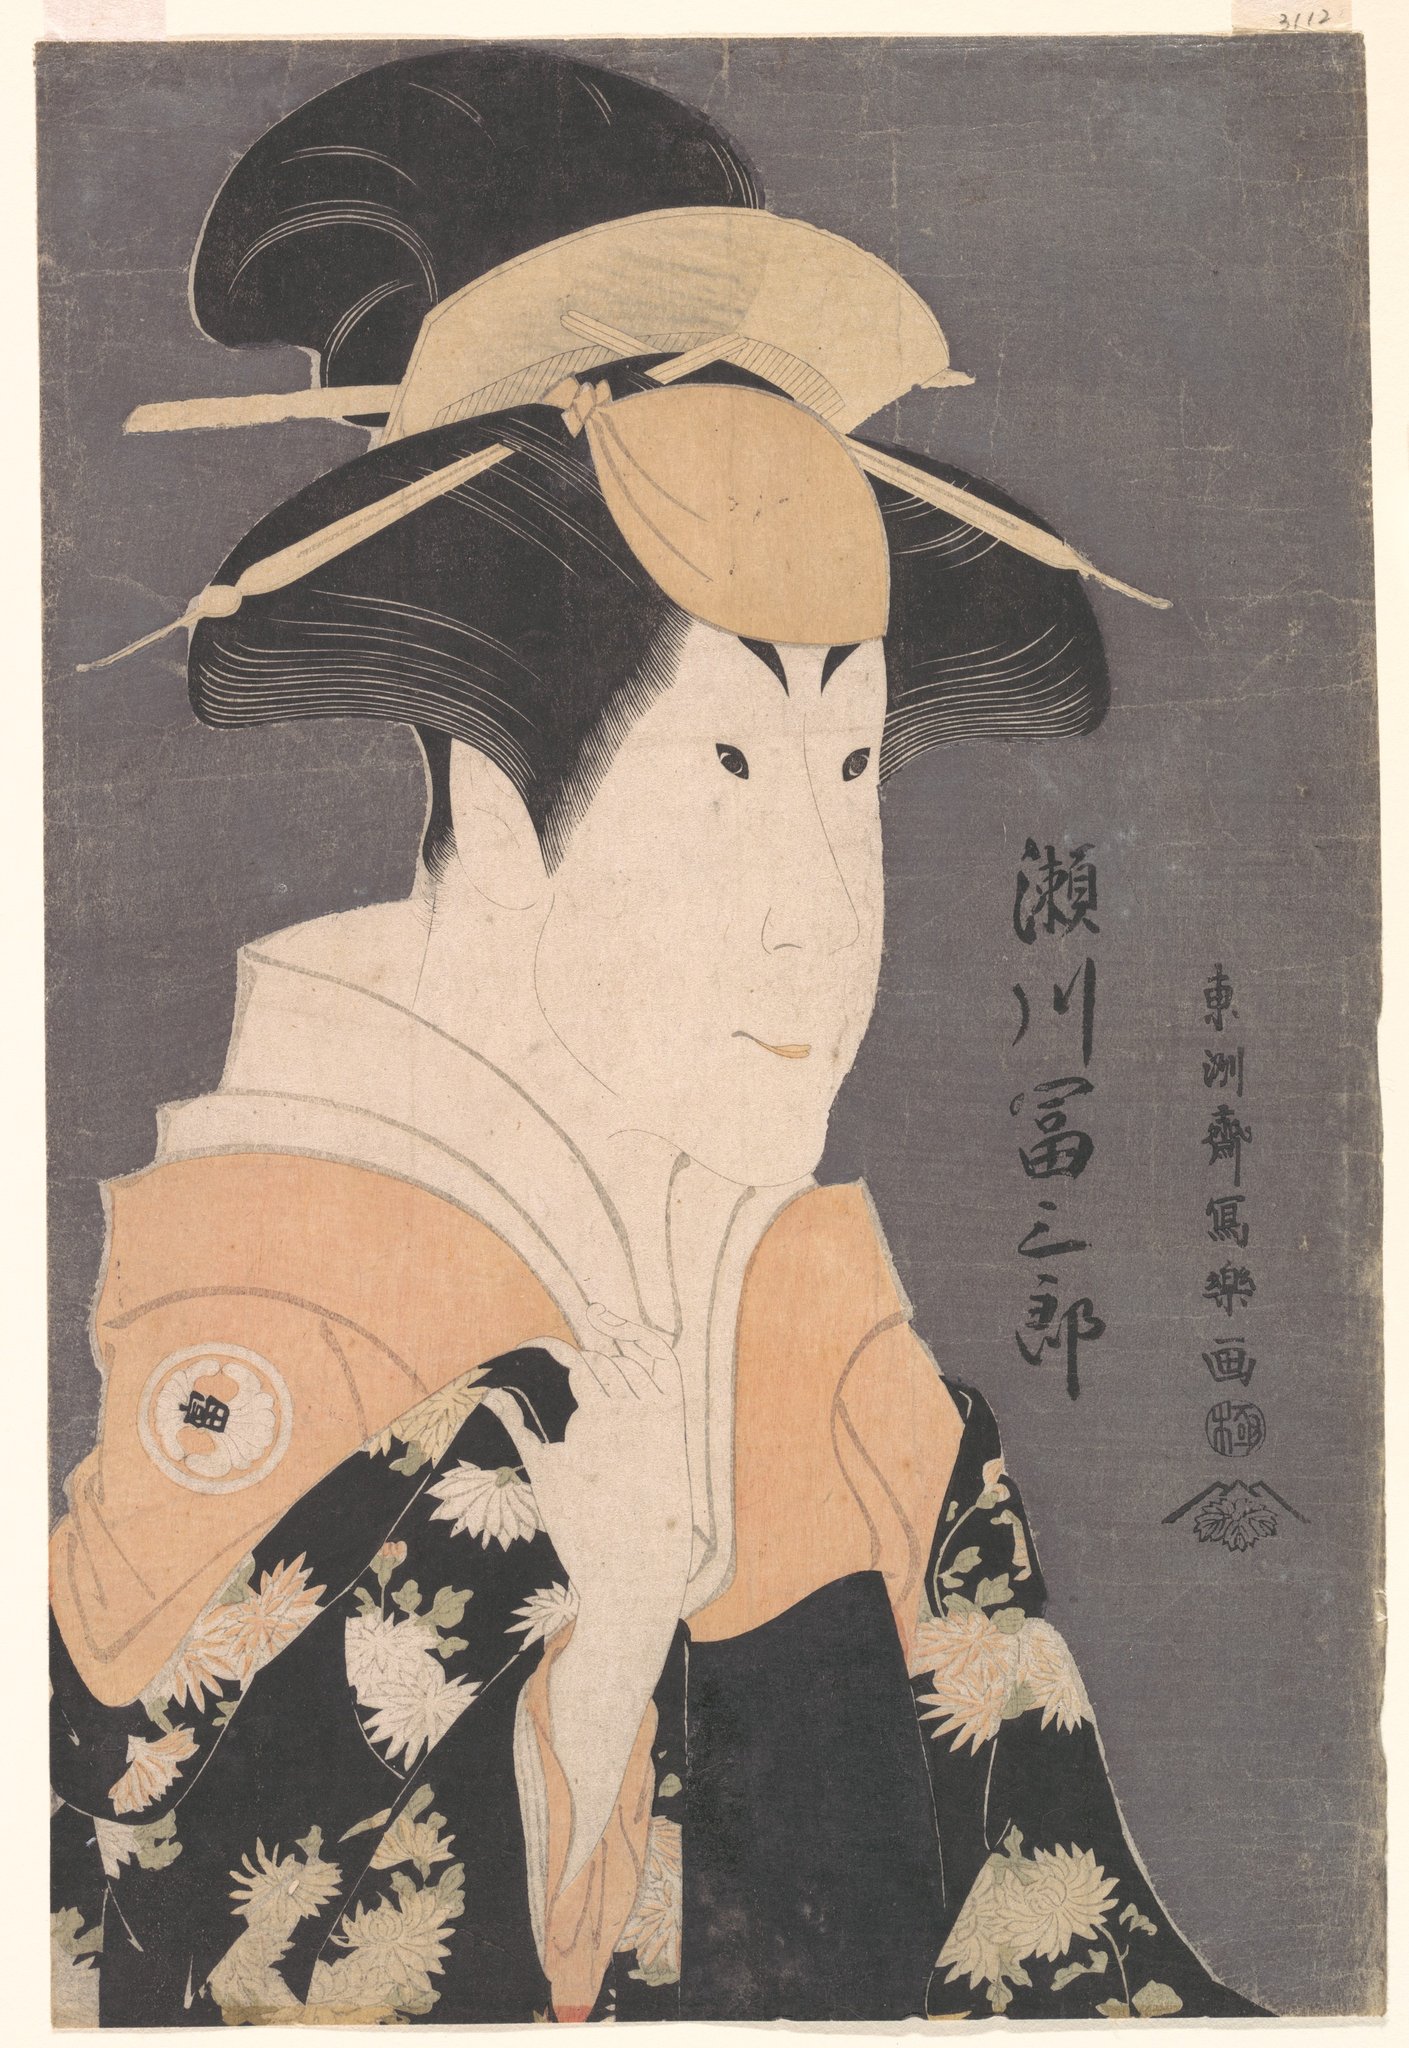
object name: print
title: Segawa Tomisaburō II as Yadorigi in the Play "Hana Ayame Bunroku Soga"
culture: japanese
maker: tōshūsai sharaku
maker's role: artist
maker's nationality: japanese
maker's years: 1794-1795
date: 1794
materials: ink, mica, paper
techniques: woodblock print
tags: men,women,actors